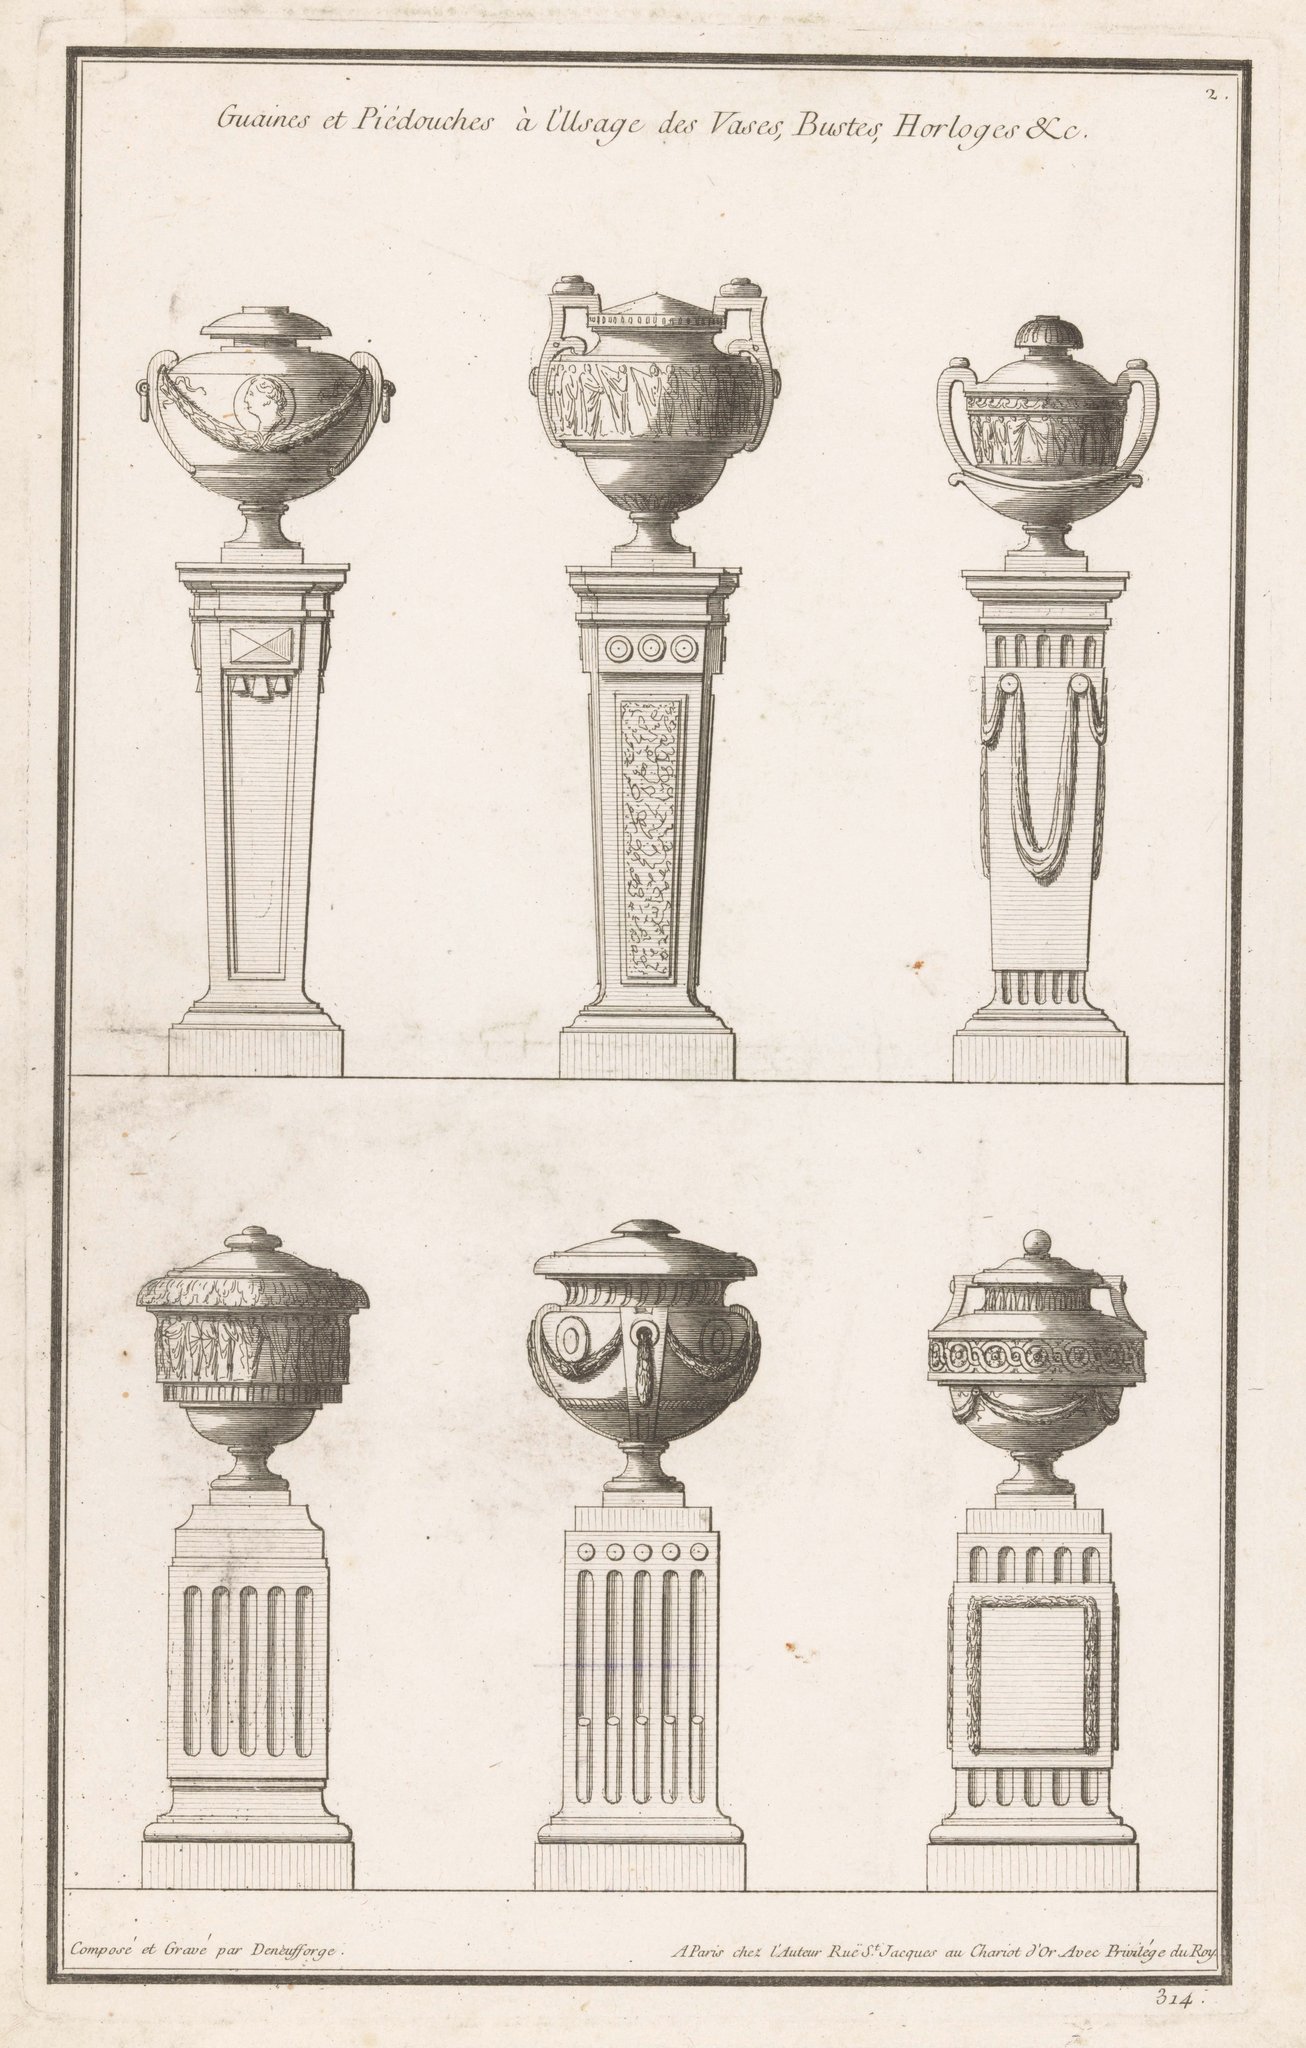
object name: print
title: Vazen op hoge voetstukken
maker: jean françois de neufforge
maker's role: print maker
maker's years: 1714-1791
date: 1763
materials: paper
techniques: etching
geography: paris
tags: vase ~ ornament, pedestal of a piece of sculpture (perhaps in the form of a herm)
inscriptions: collector's mark: Lugt 2228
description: Zes geornamenteerde vazen met guirlandes, medaillon en figuren op hoge voetstukken. Prentnummer 314.